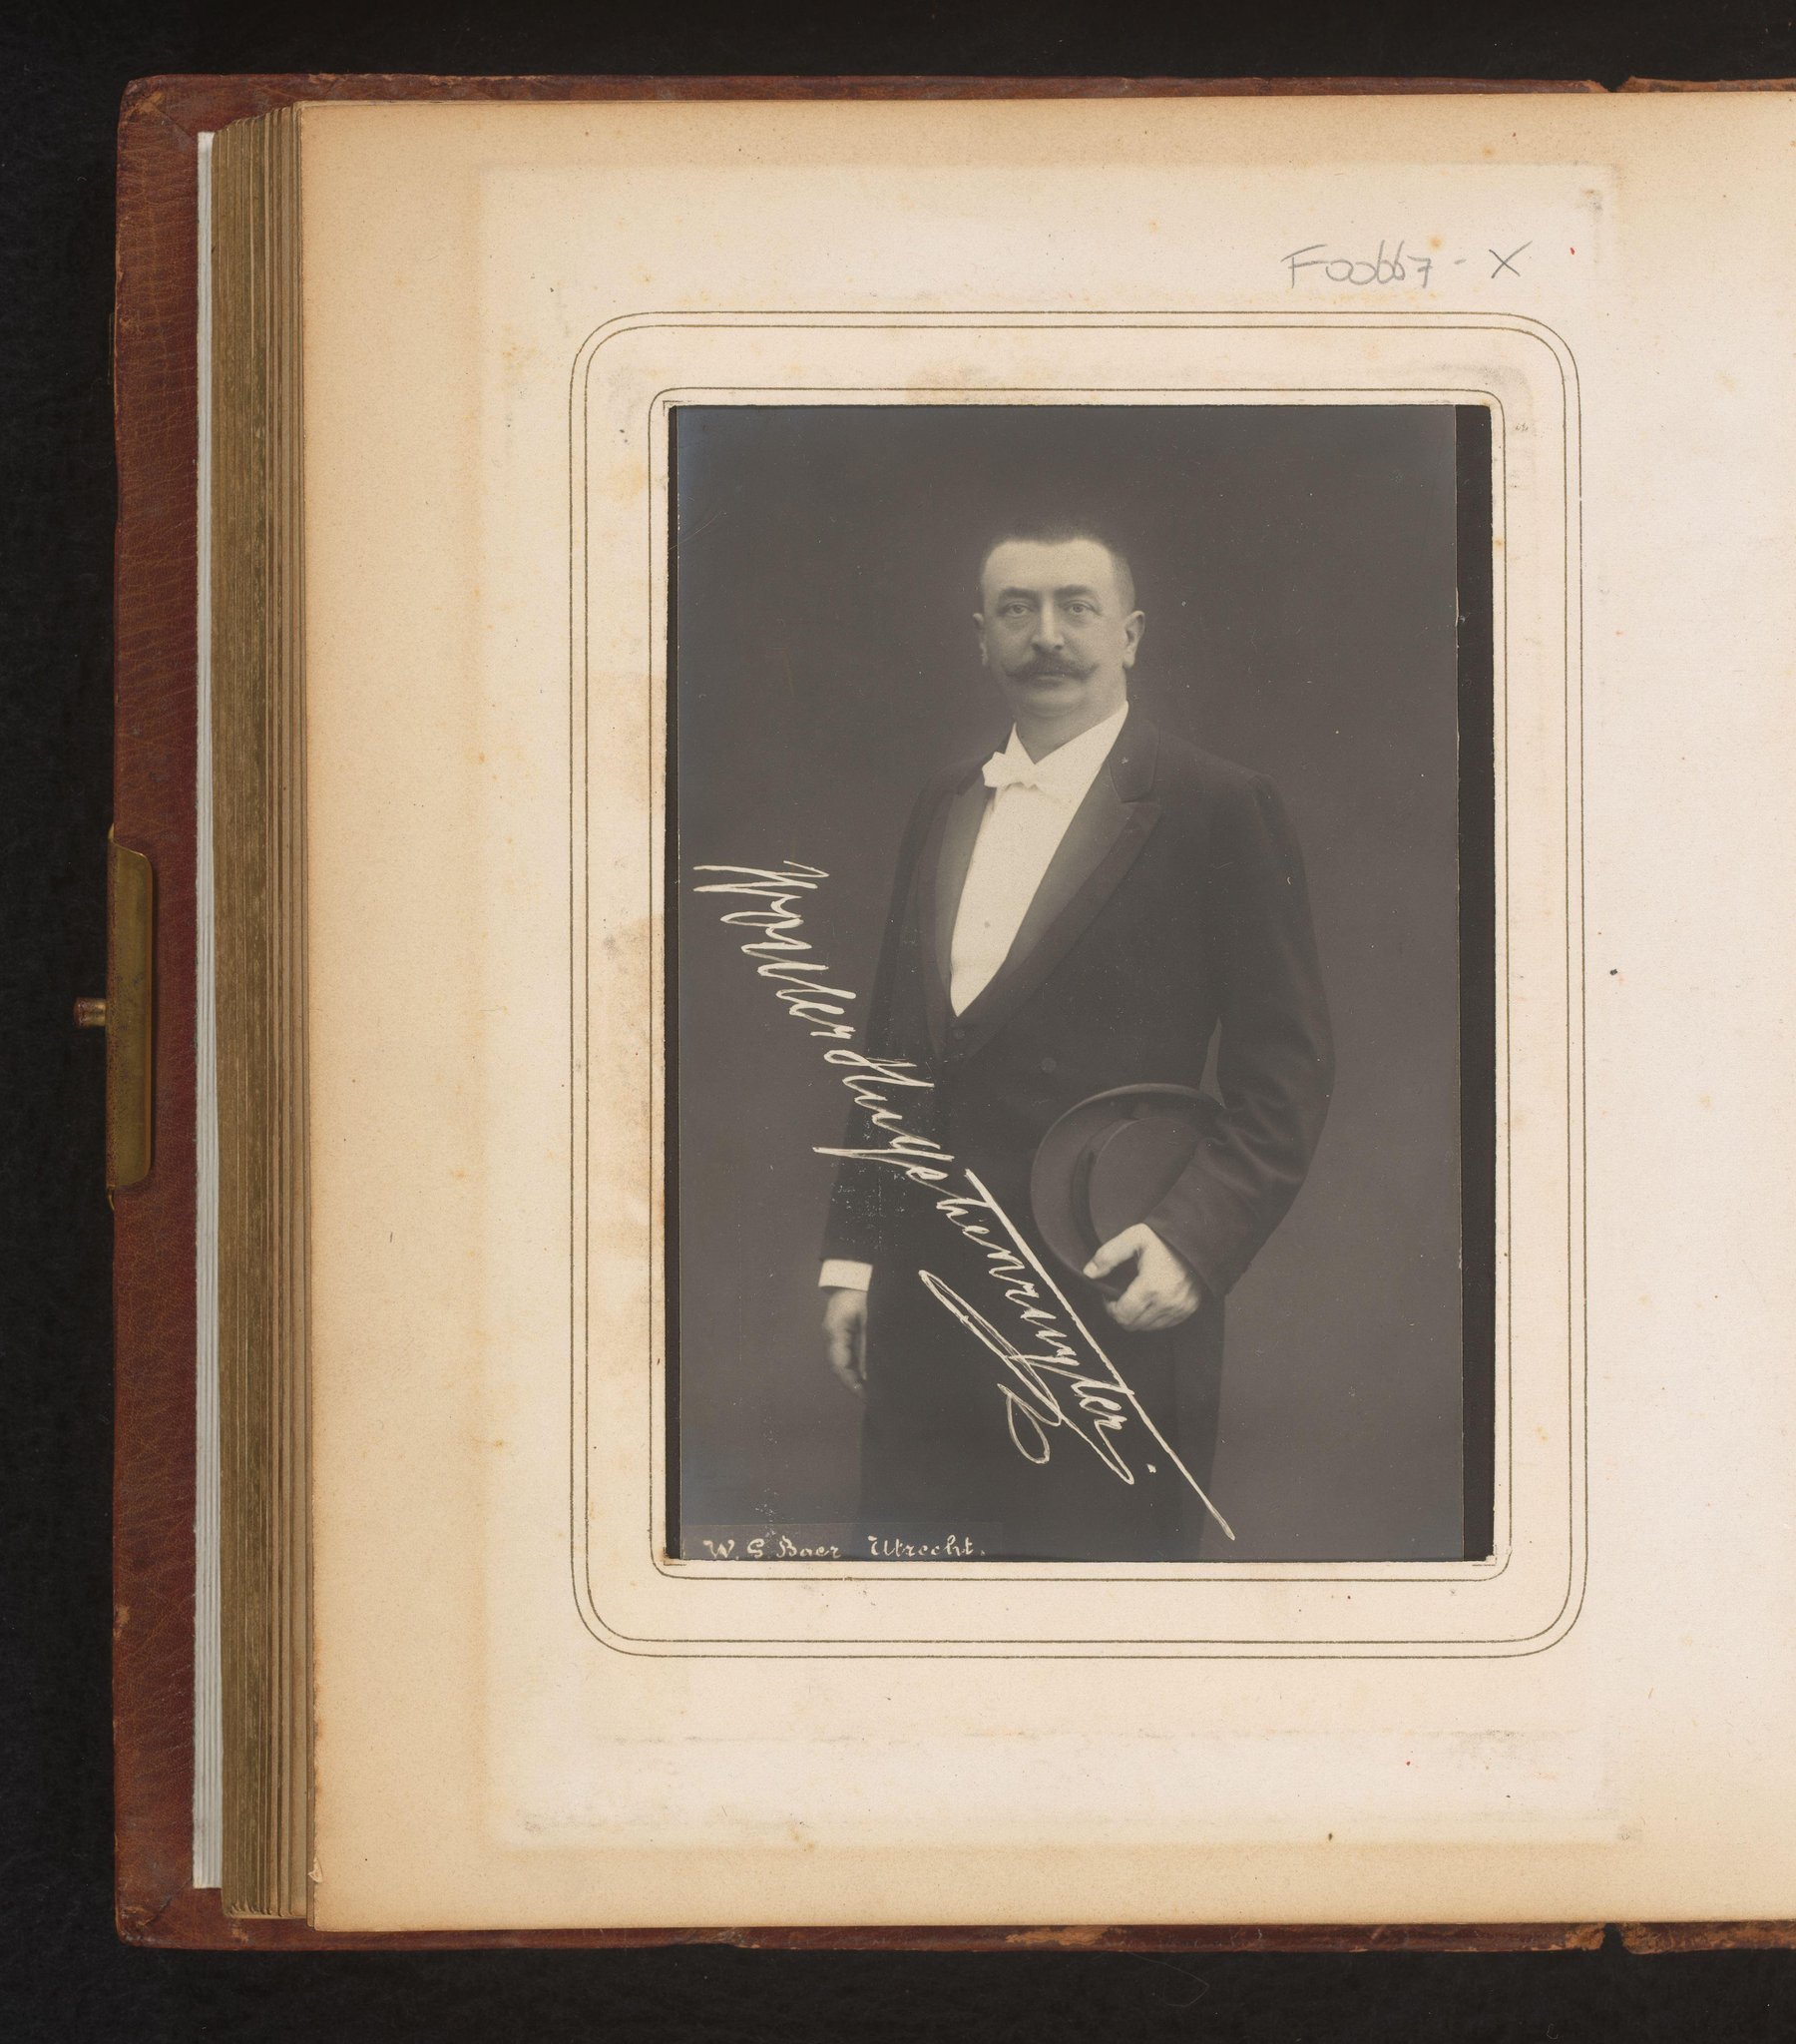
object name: album leaf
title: Portret van Wouter Hugo Tienruyter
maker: wilhelm gerardus baer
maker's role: fotograaf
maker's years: 1866-1938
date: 1900-1920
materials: cardboard, photographic support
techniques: gelatin silver print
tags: adult man, historical persons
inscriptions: name: ‘Wouter Hugo Tienruyter’